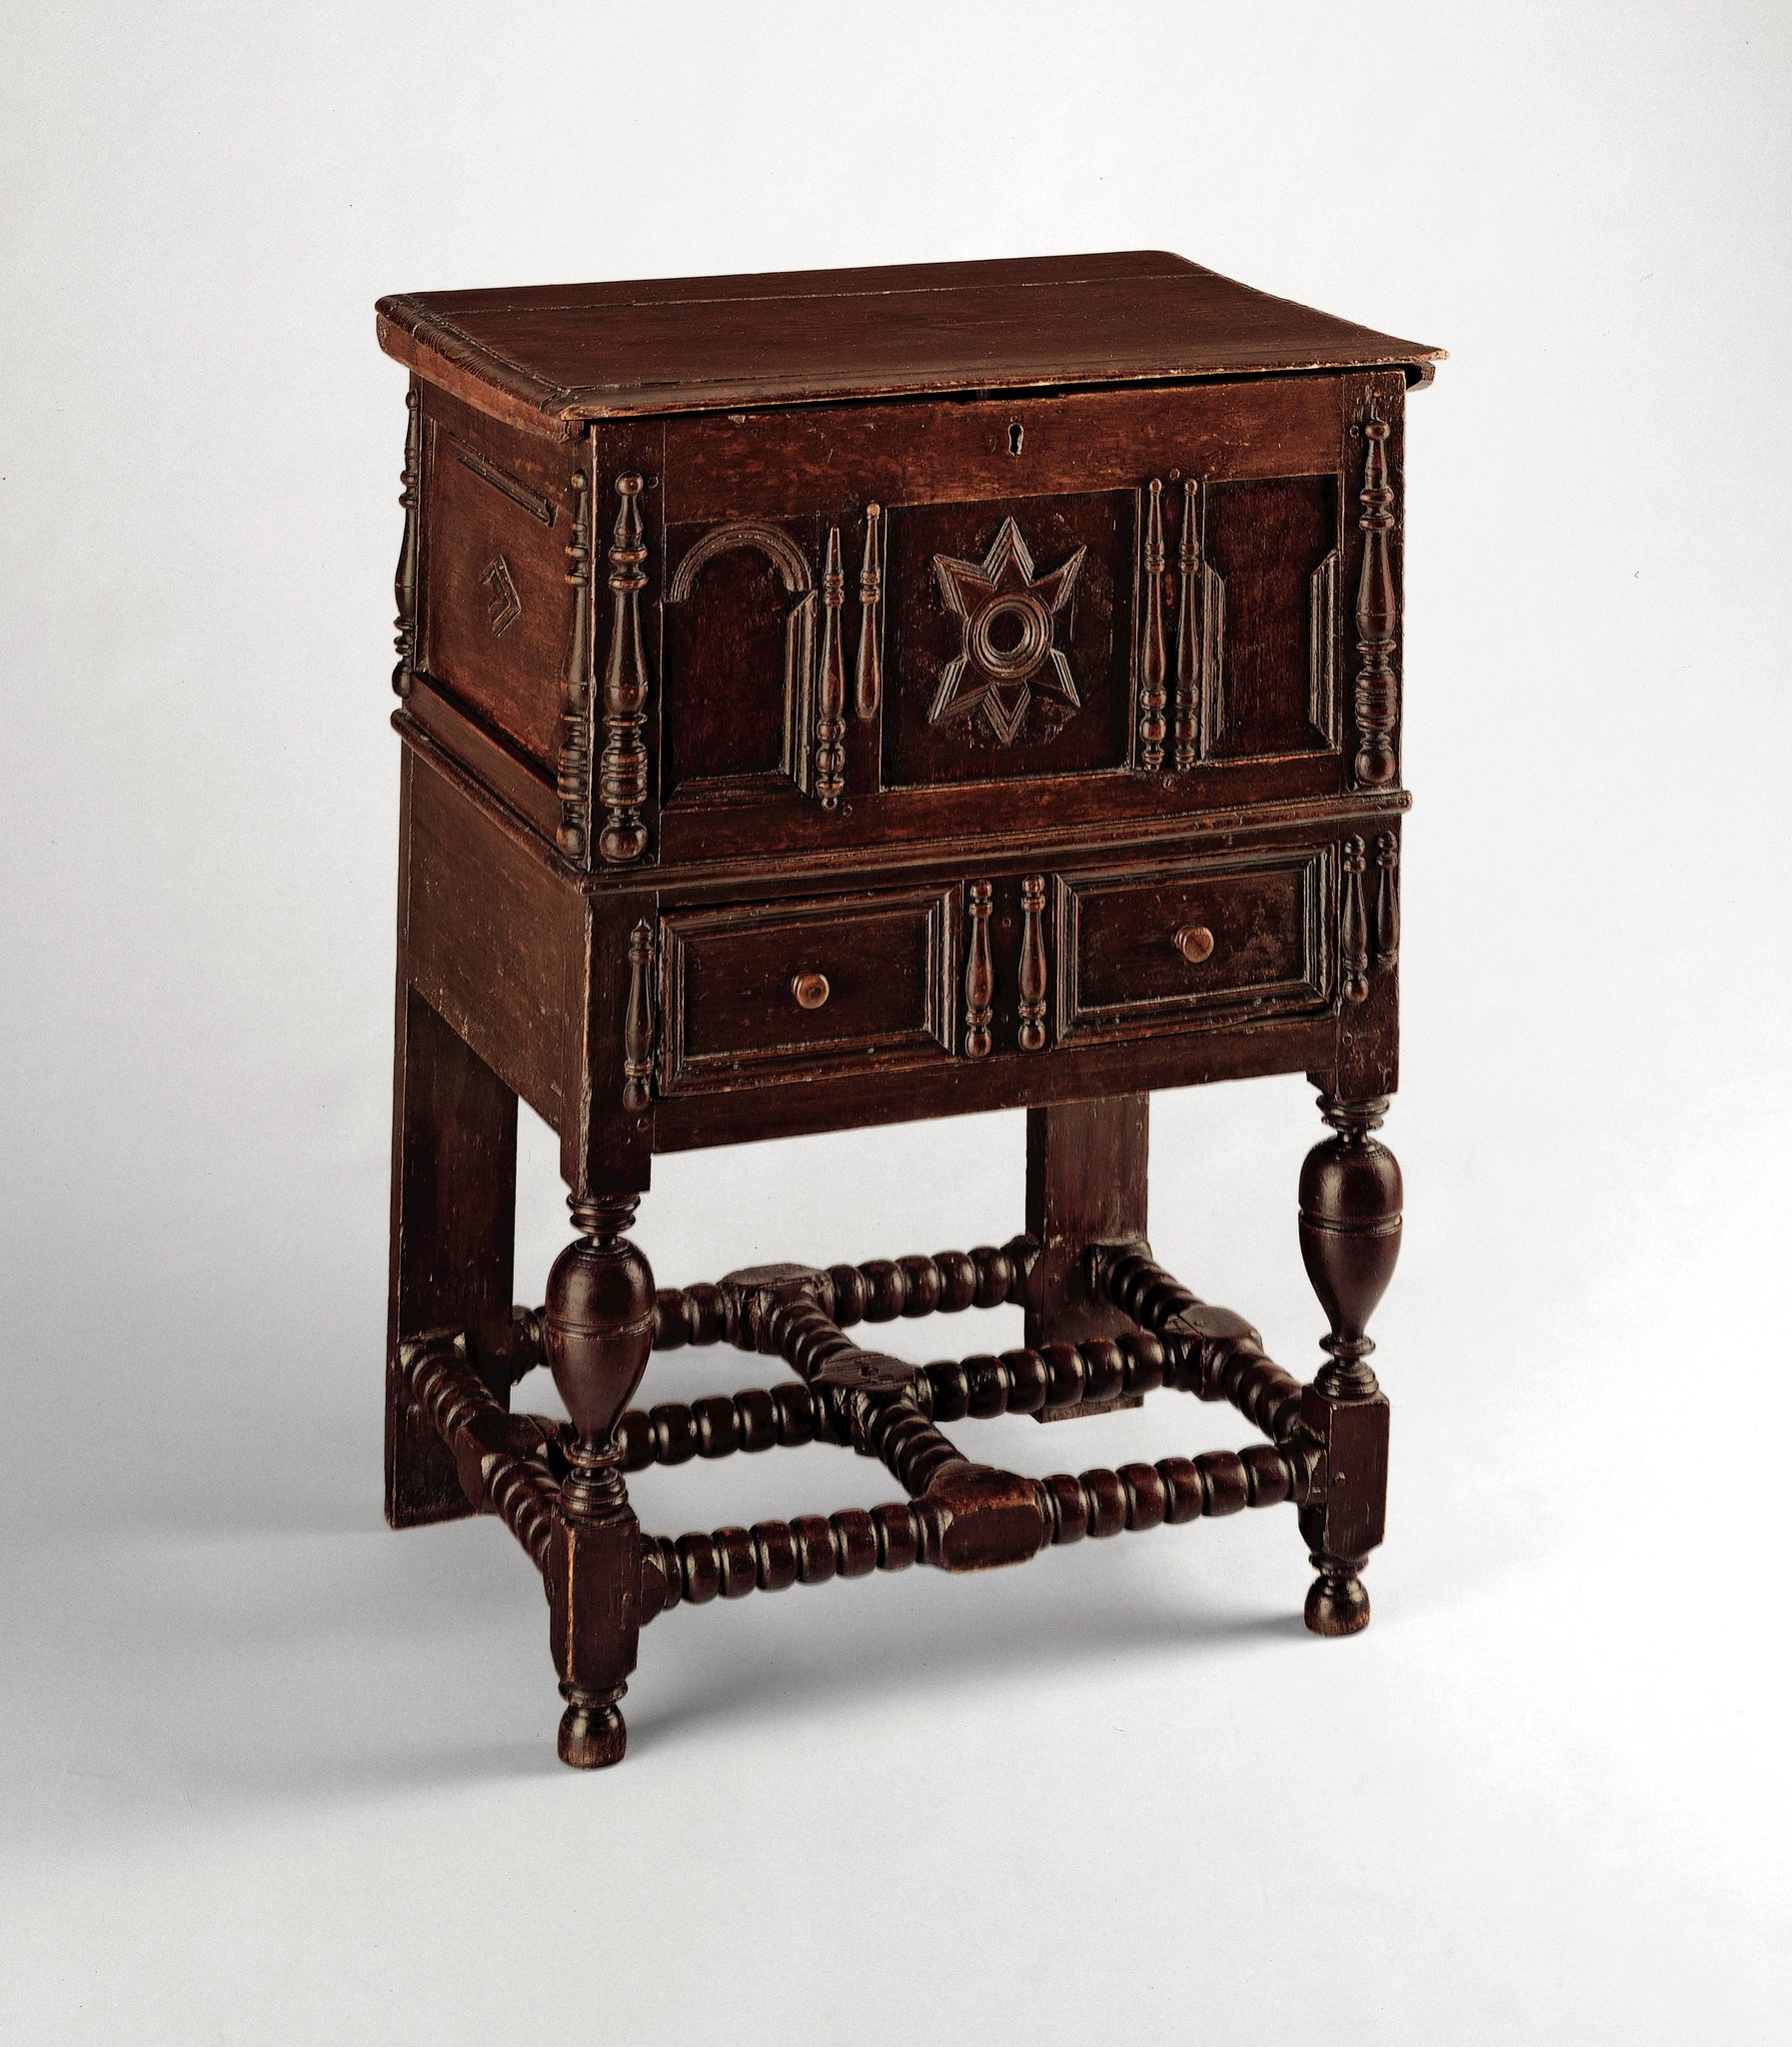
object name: chest on frame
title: Chest-on-frame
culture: american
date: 1670-1700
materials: wood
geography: united states